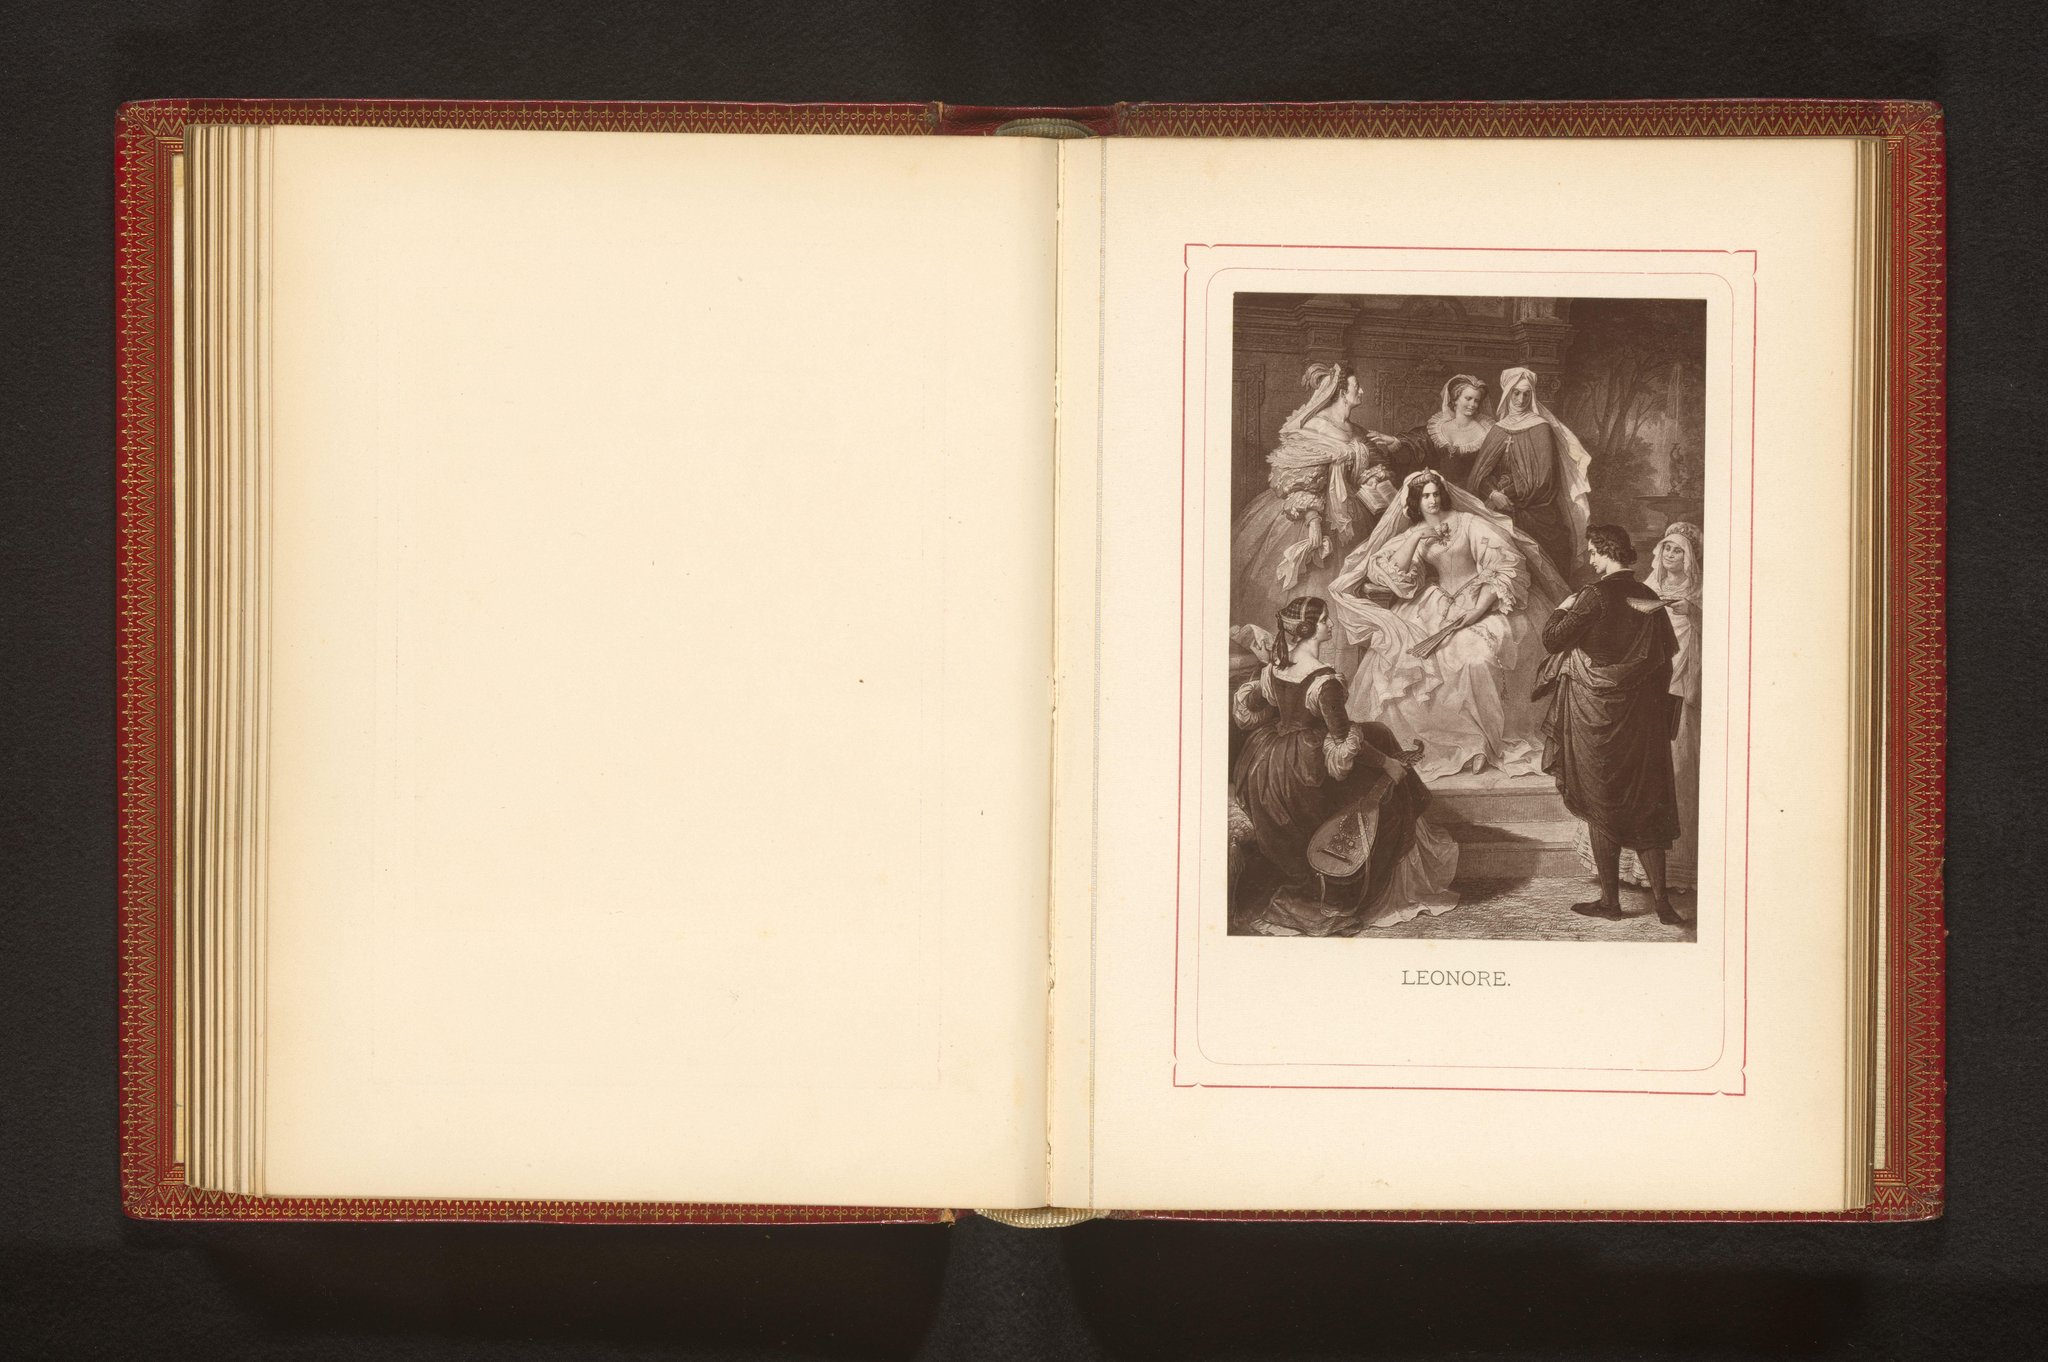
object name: reproduction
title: Fotoreproductie van een tekening, voorstellende Alfonso voor Leonore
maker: Anonymous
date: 1875-1885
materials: paper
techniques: photograph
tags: adult woman, adult man